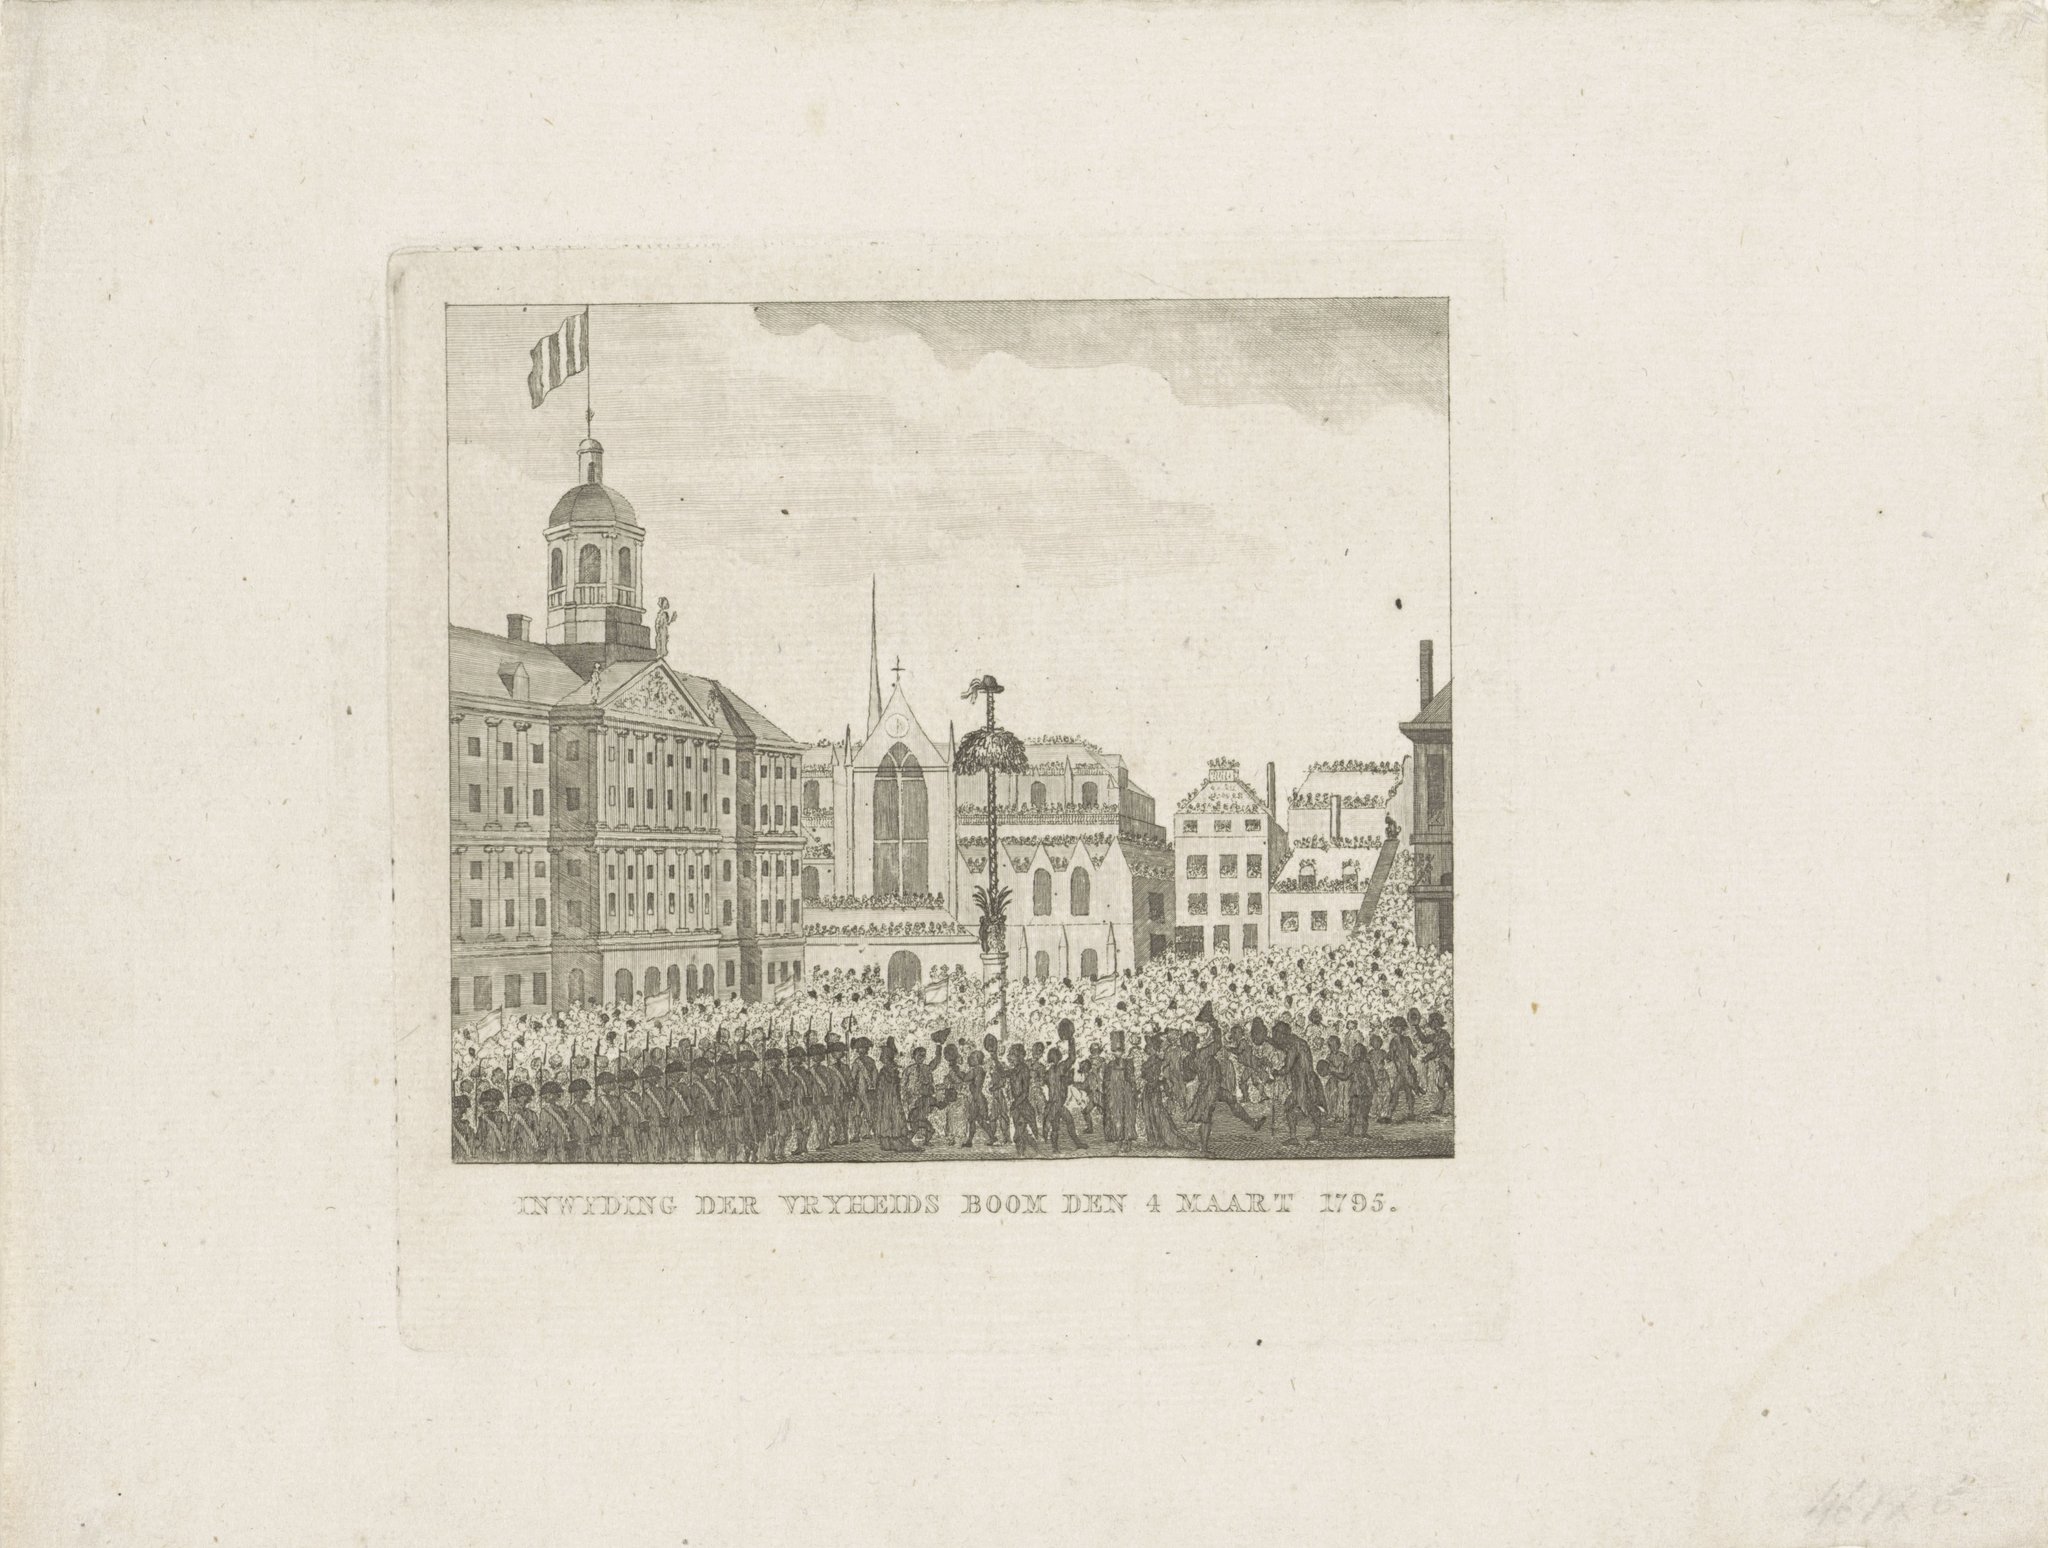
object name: print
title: Inwyding der Vryheids Boom den 4 Maart 1795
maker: Anonymous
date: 1795-1799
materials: paper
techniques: etching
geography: netherlands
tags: dancing around the tree of liberty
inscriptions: collector's mark: Lugt 2228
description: Feest der Vrijheid, gevierd bij de inwijding van de vrijheidsboom op de Dam te Amsterdam, 4 maart 1795. Gezicht op de Dam met een grote menigte dansend om de vrijheidsboom.